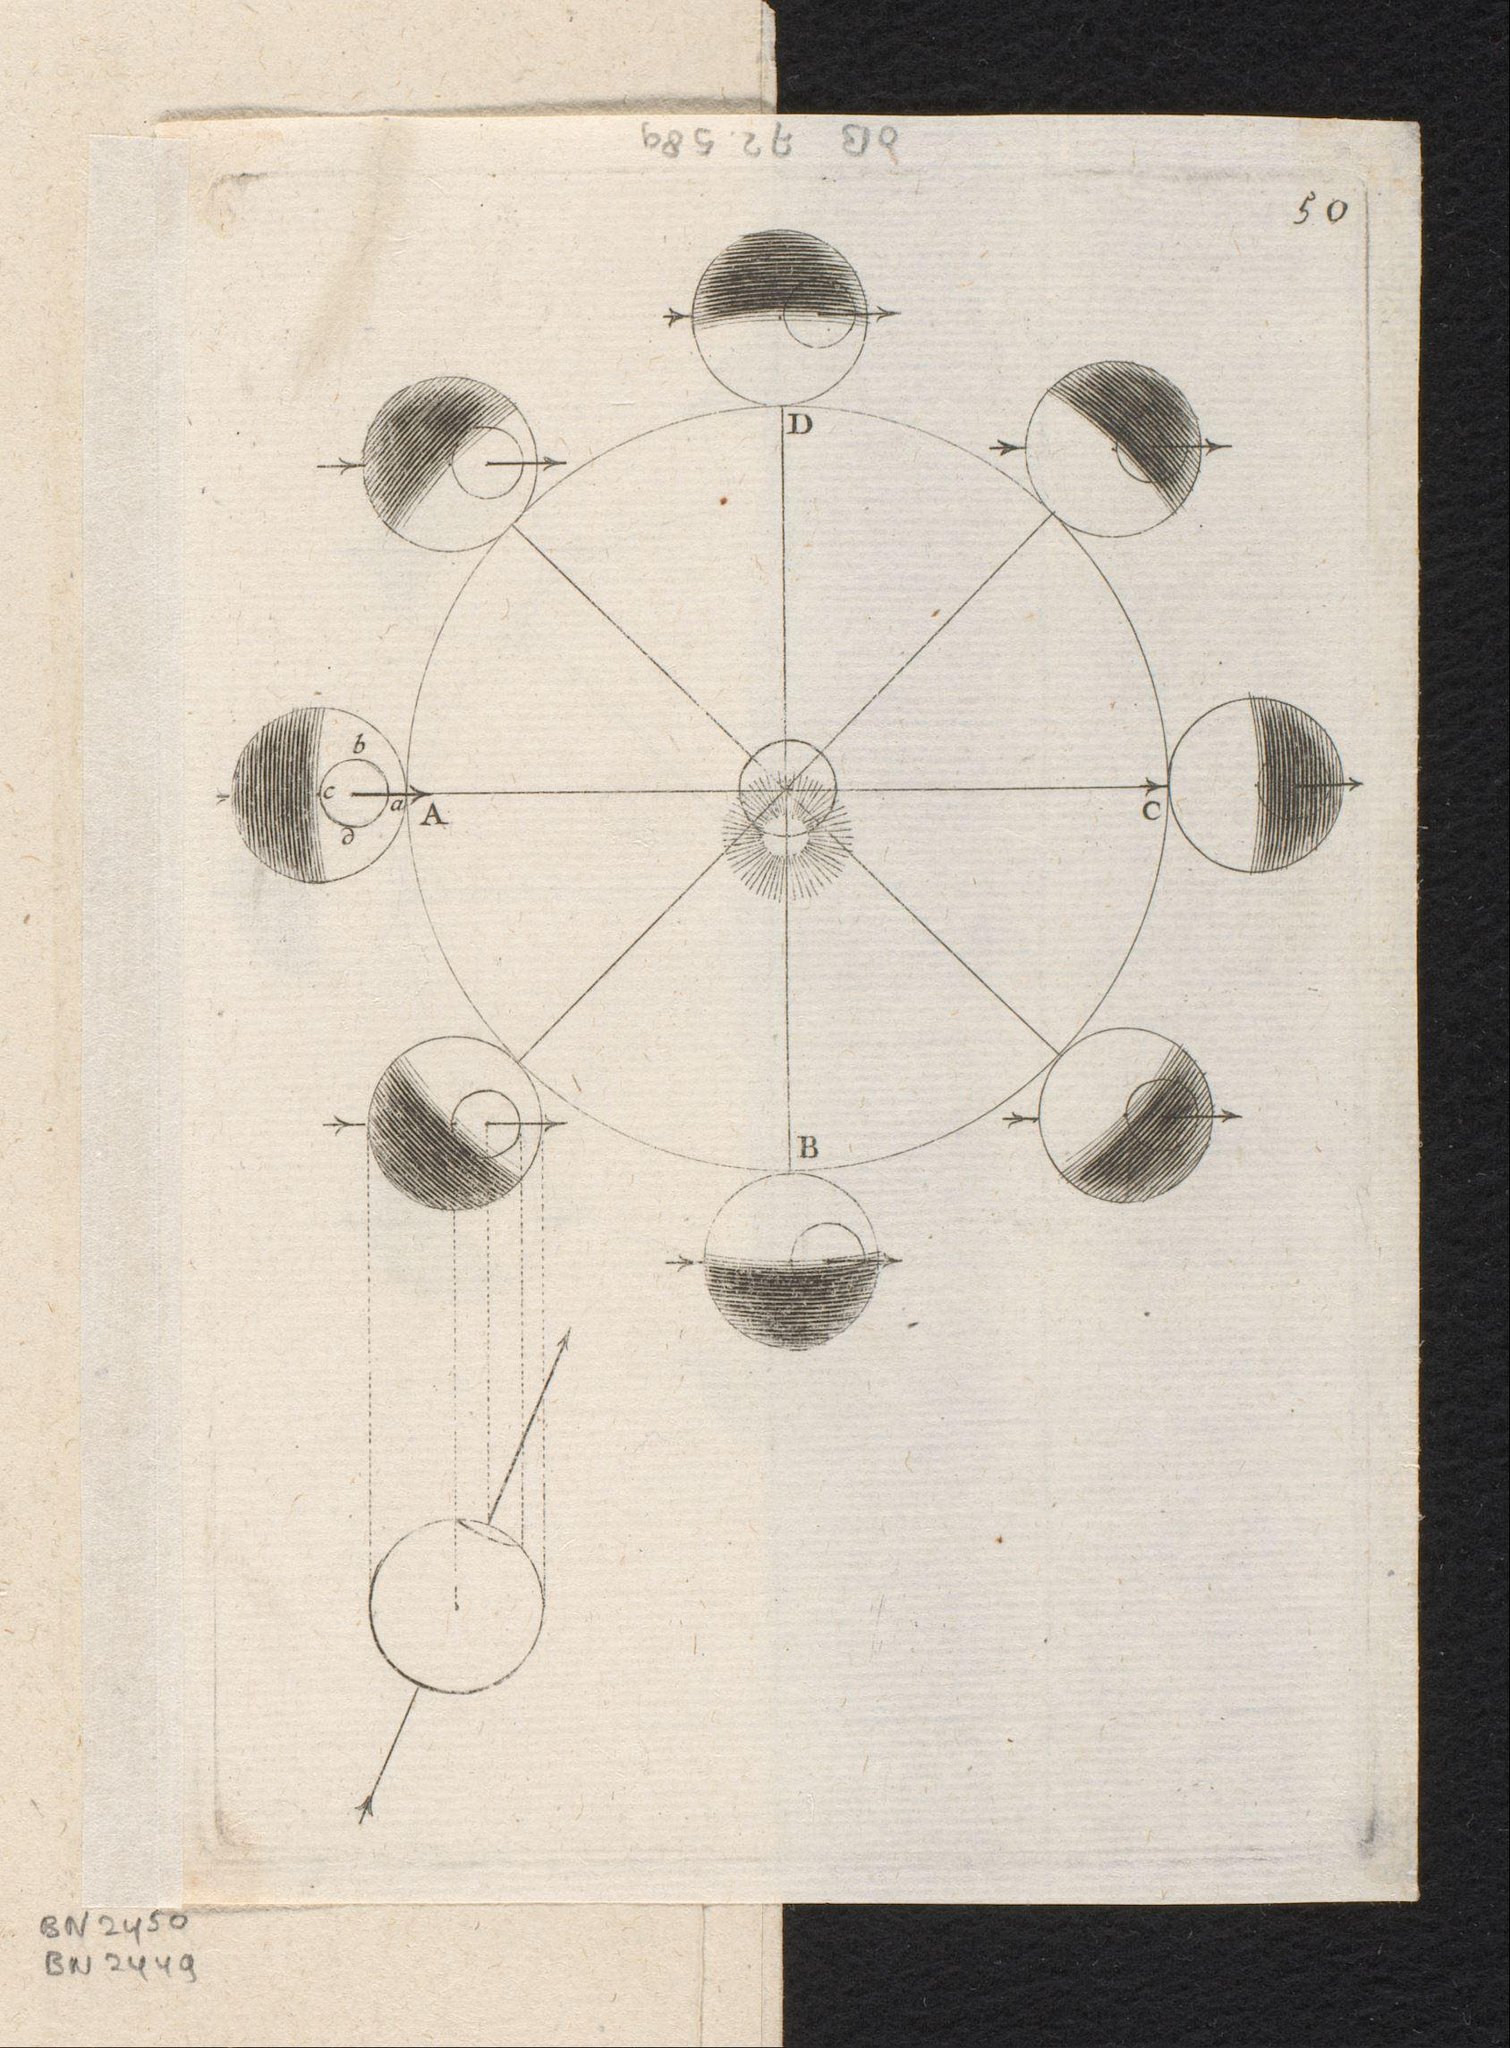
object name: print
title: Beweging van de Aarde rond de Zon en de evolutie van de dagen en nachten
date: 1706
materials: paper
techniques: etching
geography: france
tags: earth, world as celestial body, sun as celestial body, day and night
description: Prent uit: Leclerc, Sébastien. Nouveau systeme du monde conforme à l'Ecriture sainte. Où les phénomènes sont expliquez sans excentricité de mouvement (...). Paris: Pierre Giffart, 1706.